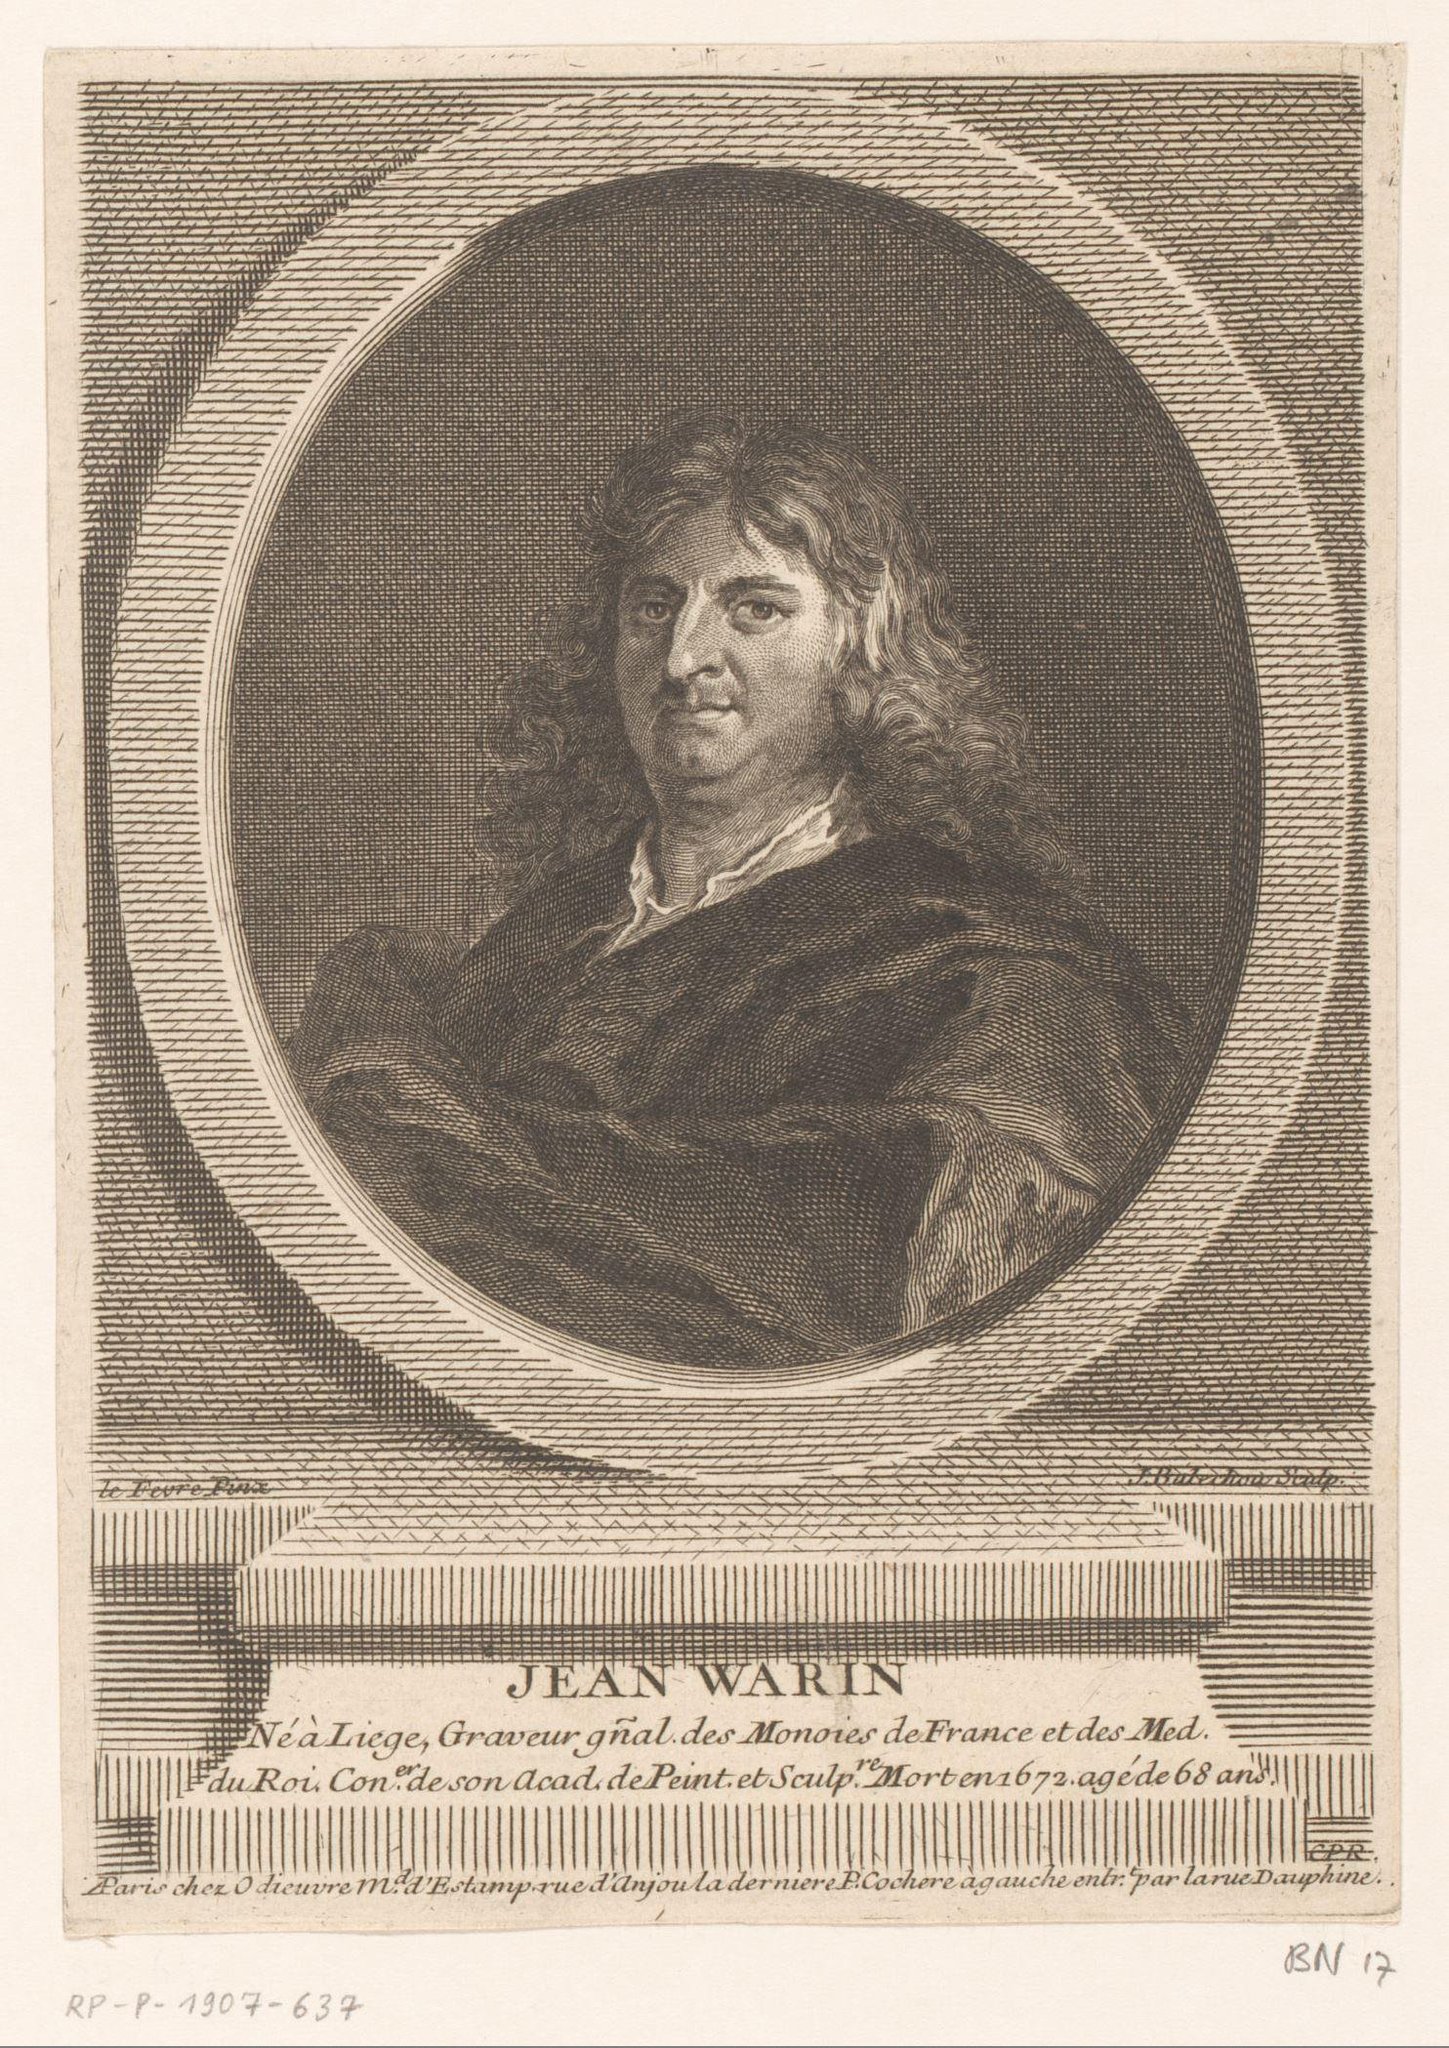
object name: print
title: Portret van Jean Varin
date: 1756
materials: paper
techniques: engraving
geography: paris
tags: jean varin, ornament ~ medallion, historical persons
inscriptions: collector's mark: Lugt 2228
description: Prent waarschijnlijk uit: Dreux du Radier, Jean François. L'Europe illustré, contenant l'histoire abregée des souverains, des princes, des prélats, des ministres (...). Parijs: Le Breton, 1765, dl. 6.